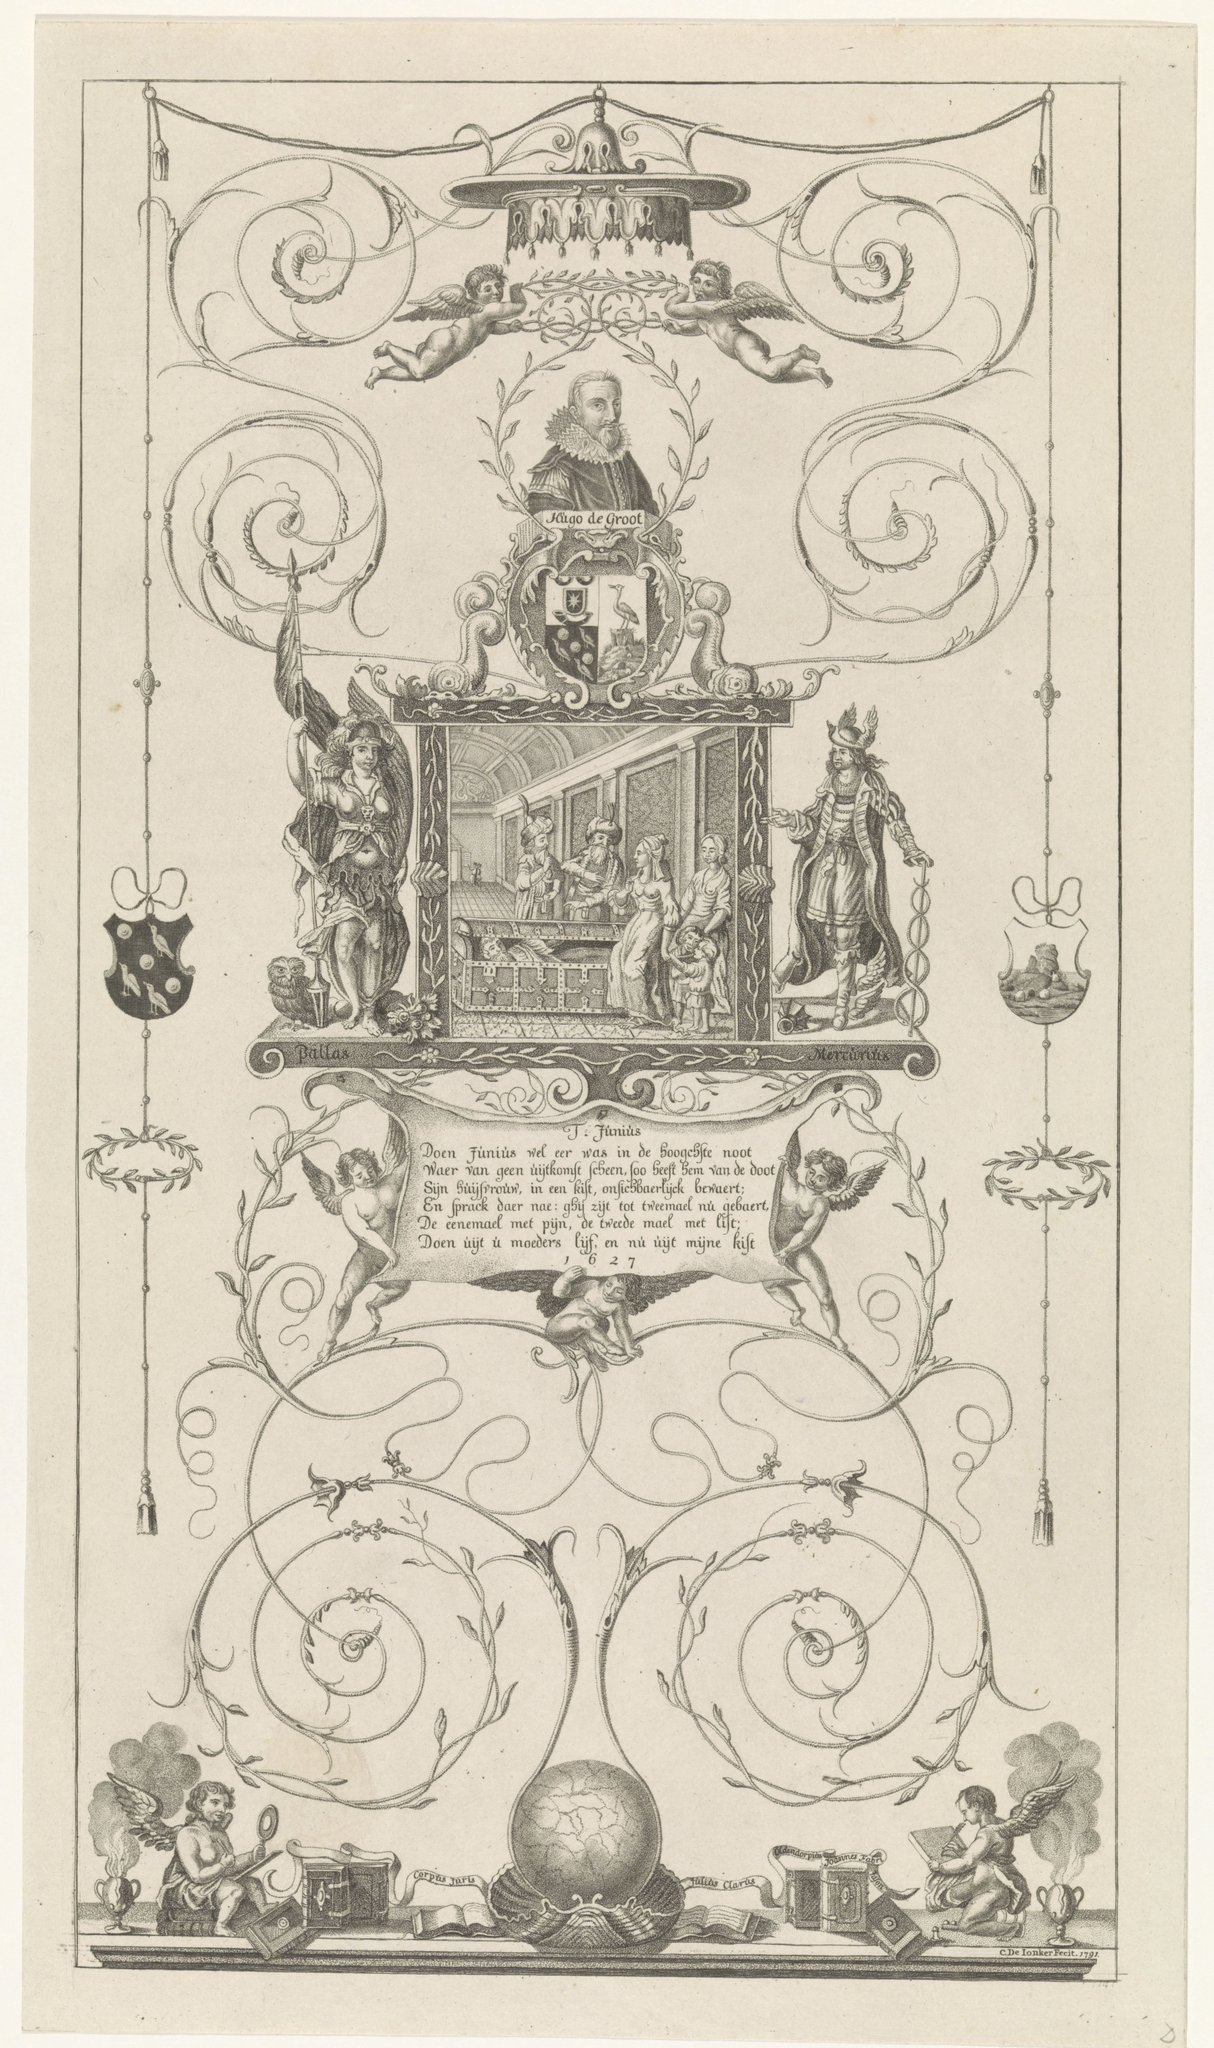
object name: print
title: Zinneprent met gevangenneming van Hugo de Groot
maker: cornelis de jonker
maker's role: draughtsman, print maker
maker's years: 1761-1830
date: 1791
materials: paper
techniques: engraving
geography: gorinchem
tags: delft, hugo de groot, (story of) minerva (pallas, athena), (story of) mercury (hermes)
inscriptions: collector's mark: Lugt 2228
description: Ornamentprent met busteportret van Hugo de Groot en daaronder het wapenschild van geportretteerde. In het midden een zesregelig gedicht in Nederlands met daarboven een voorstelling van de ontsnapping van Hugo de Groot uit Loevestein in een boekenkist, geflankeerd door Athene en Mercurius.